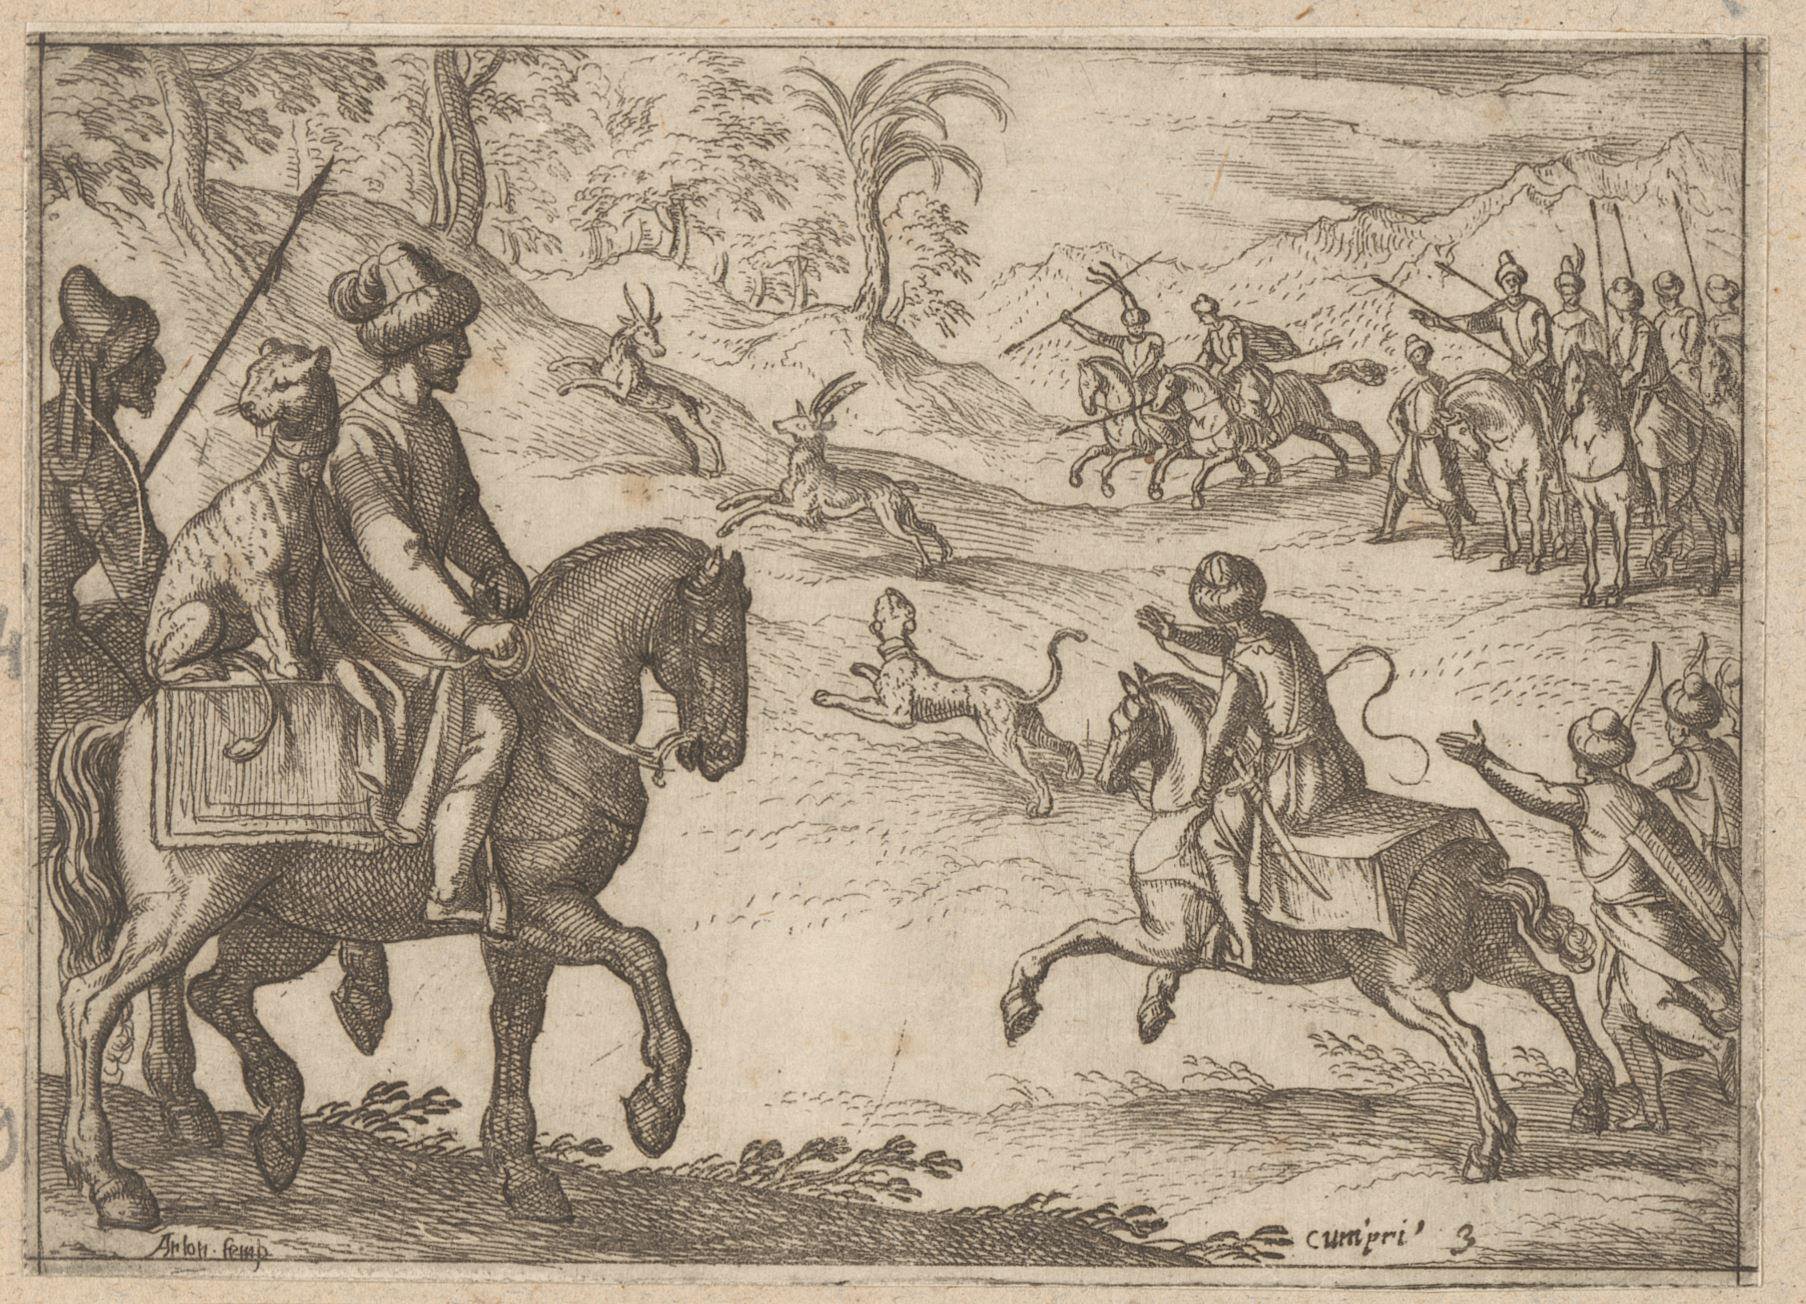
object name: print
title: Jachtscènes (deel 2)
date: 1598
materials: paper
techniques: etching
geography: vatican city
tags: beasts of prey, predatory animals: leopard, stag-hunting, hunter, hunters hunting (n.b.: in 1988-1990 this notation denoted the concept of 43c11421 'hunters resting during the hunt')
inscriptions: number: ‘3’, collector's mark: ‘Hinloopen’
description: Landschap met Oosterse mannen met tulbanden en speren te paard die op herten jagen met behulp van luipaarden. Op de voorgrond links een jager te paard met achterop een luipaard.